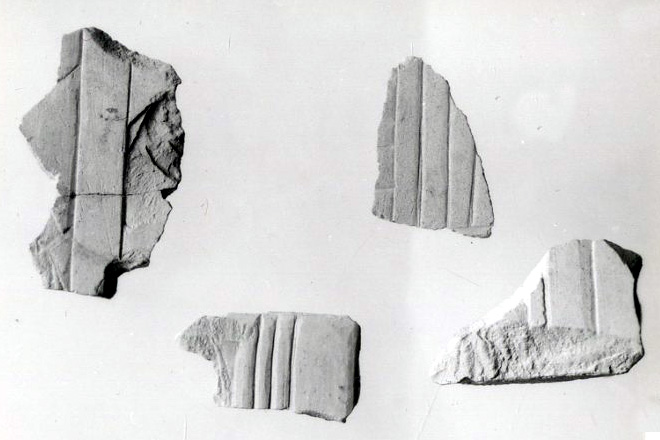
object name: relief fragment, tomb of meketre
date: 1981-1975 BCE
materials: limestone, paint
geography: egypt